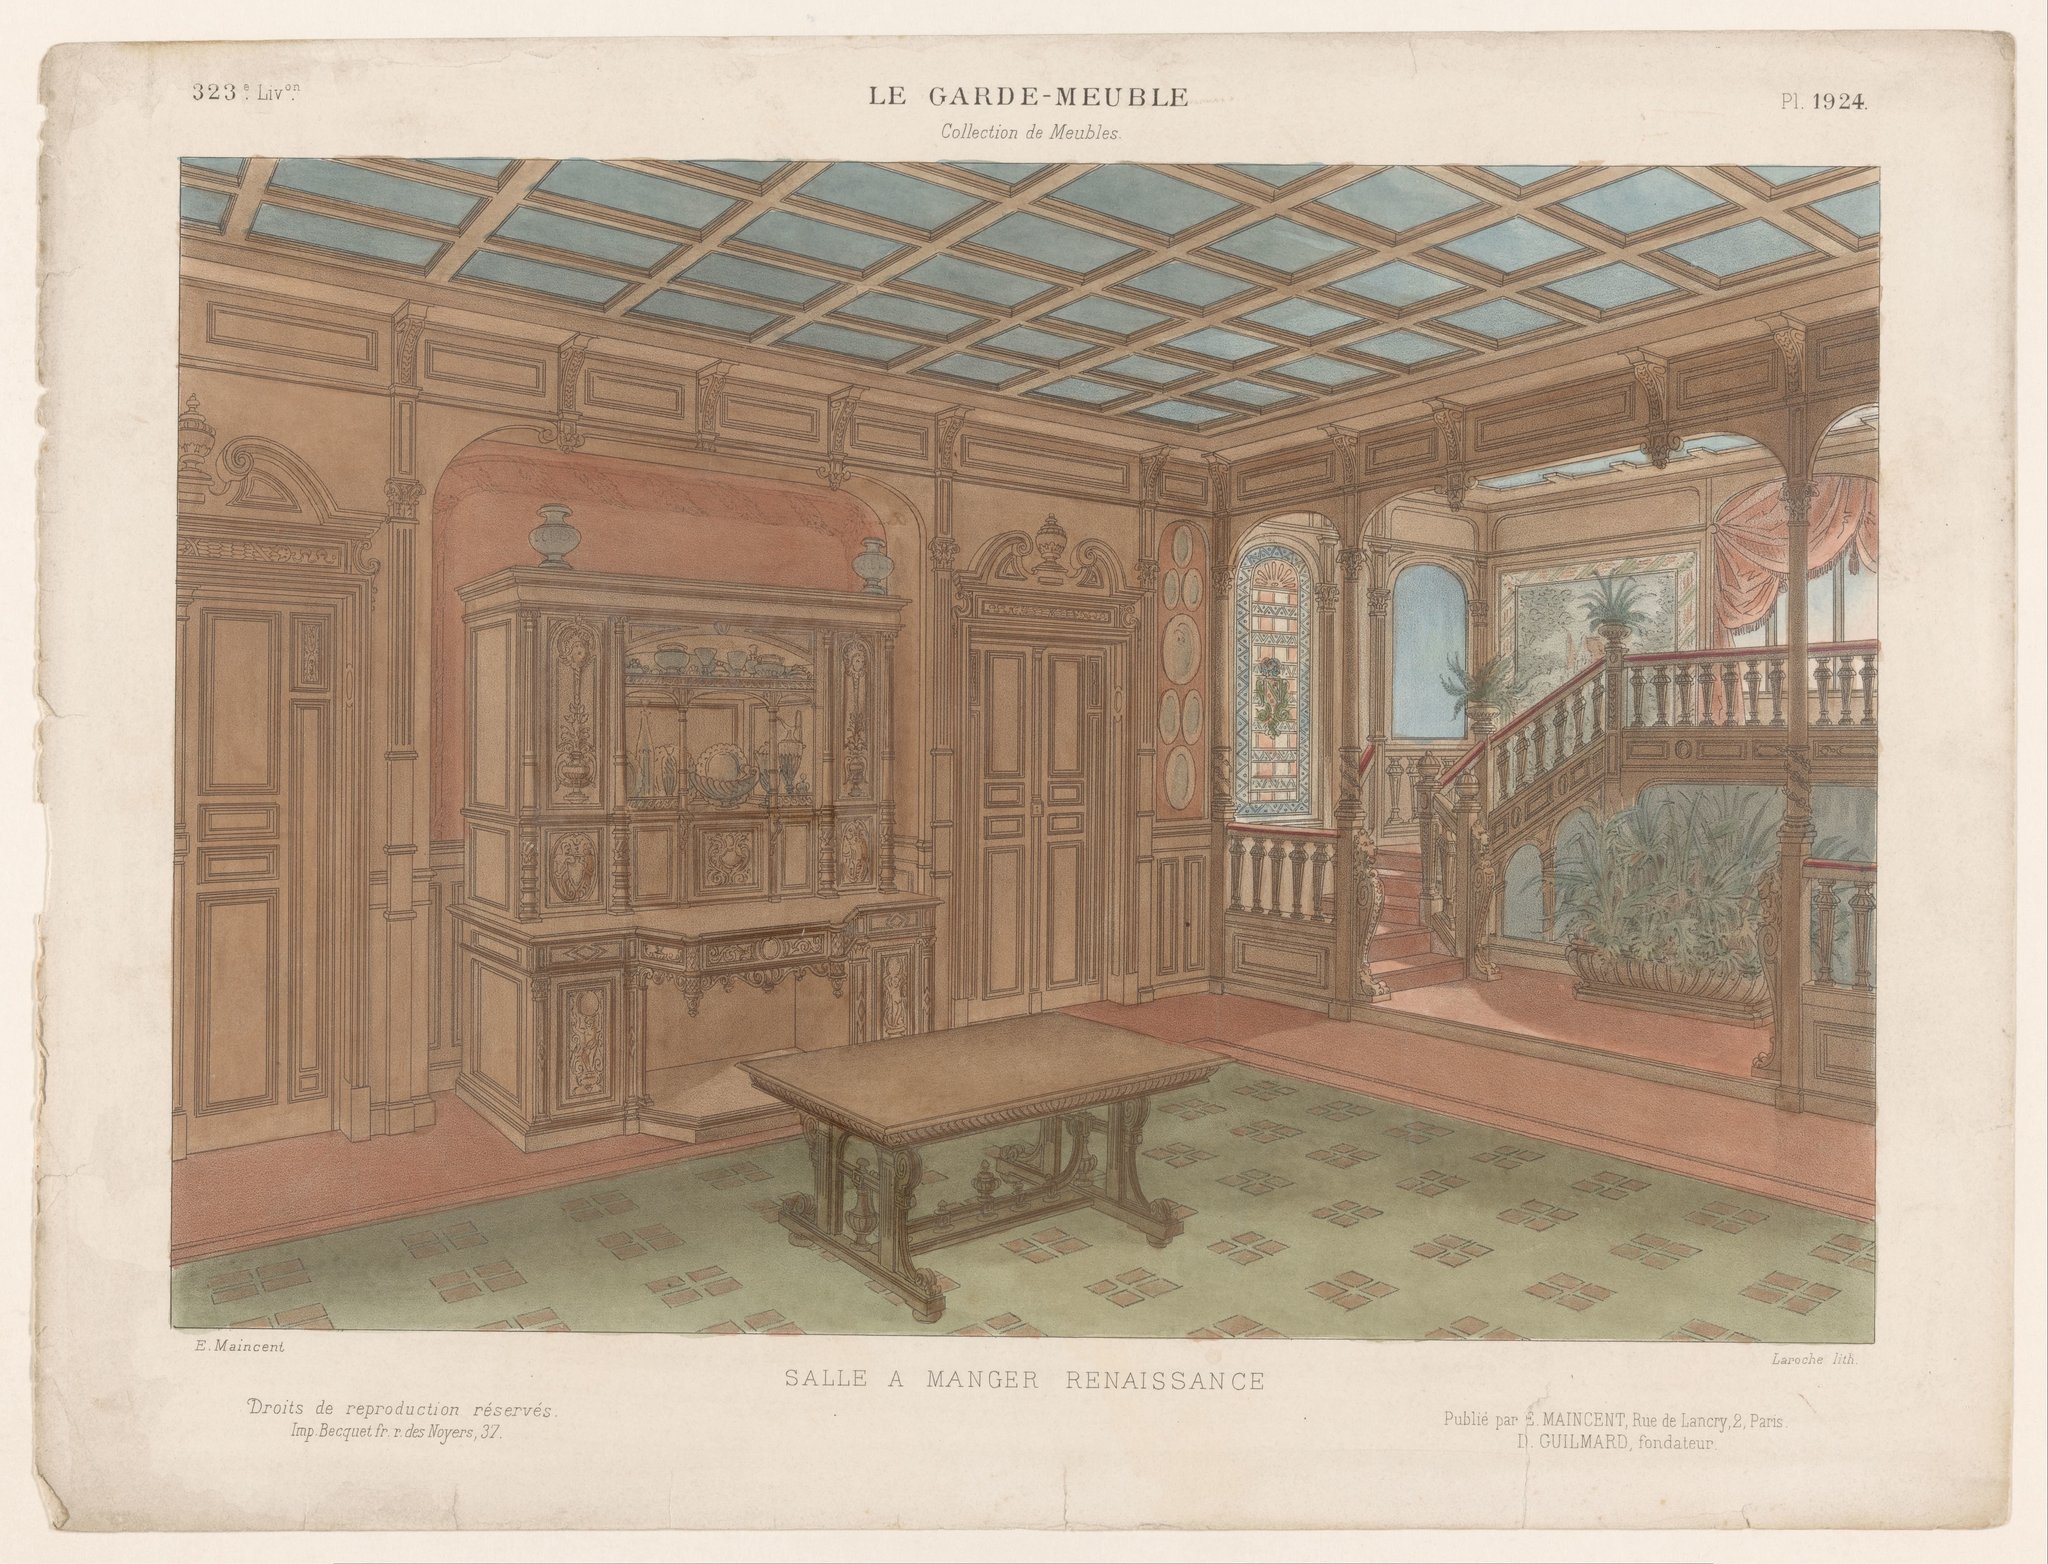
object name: print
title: Le garde-meuble / Collection de Meubles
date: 1885-1895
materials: paper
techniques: hand coloring, lithograph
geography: paris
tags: dining-room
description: Ieder Livraison in de serie Le Garde-Meuble bevat negen platen: drie 'sièges' (zitmeubels), drie 'meubles' (diverse meubels zoals tafels en kasten) en drie 'tentures' (gordijnen en draperieën).